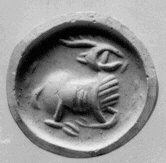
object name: stamp seal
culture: sasanian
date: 201-700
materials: mineral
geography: iran or mesopotamia